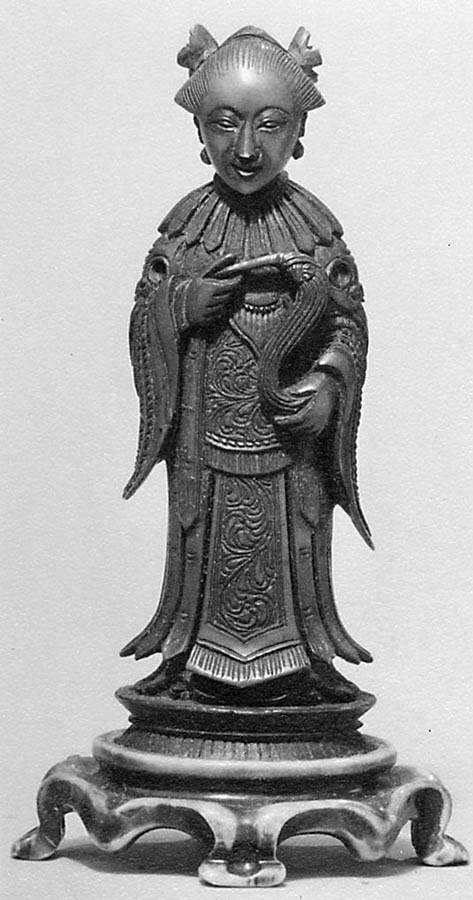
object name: chess piece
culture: chinese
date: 1867-1900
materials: ivory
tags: women